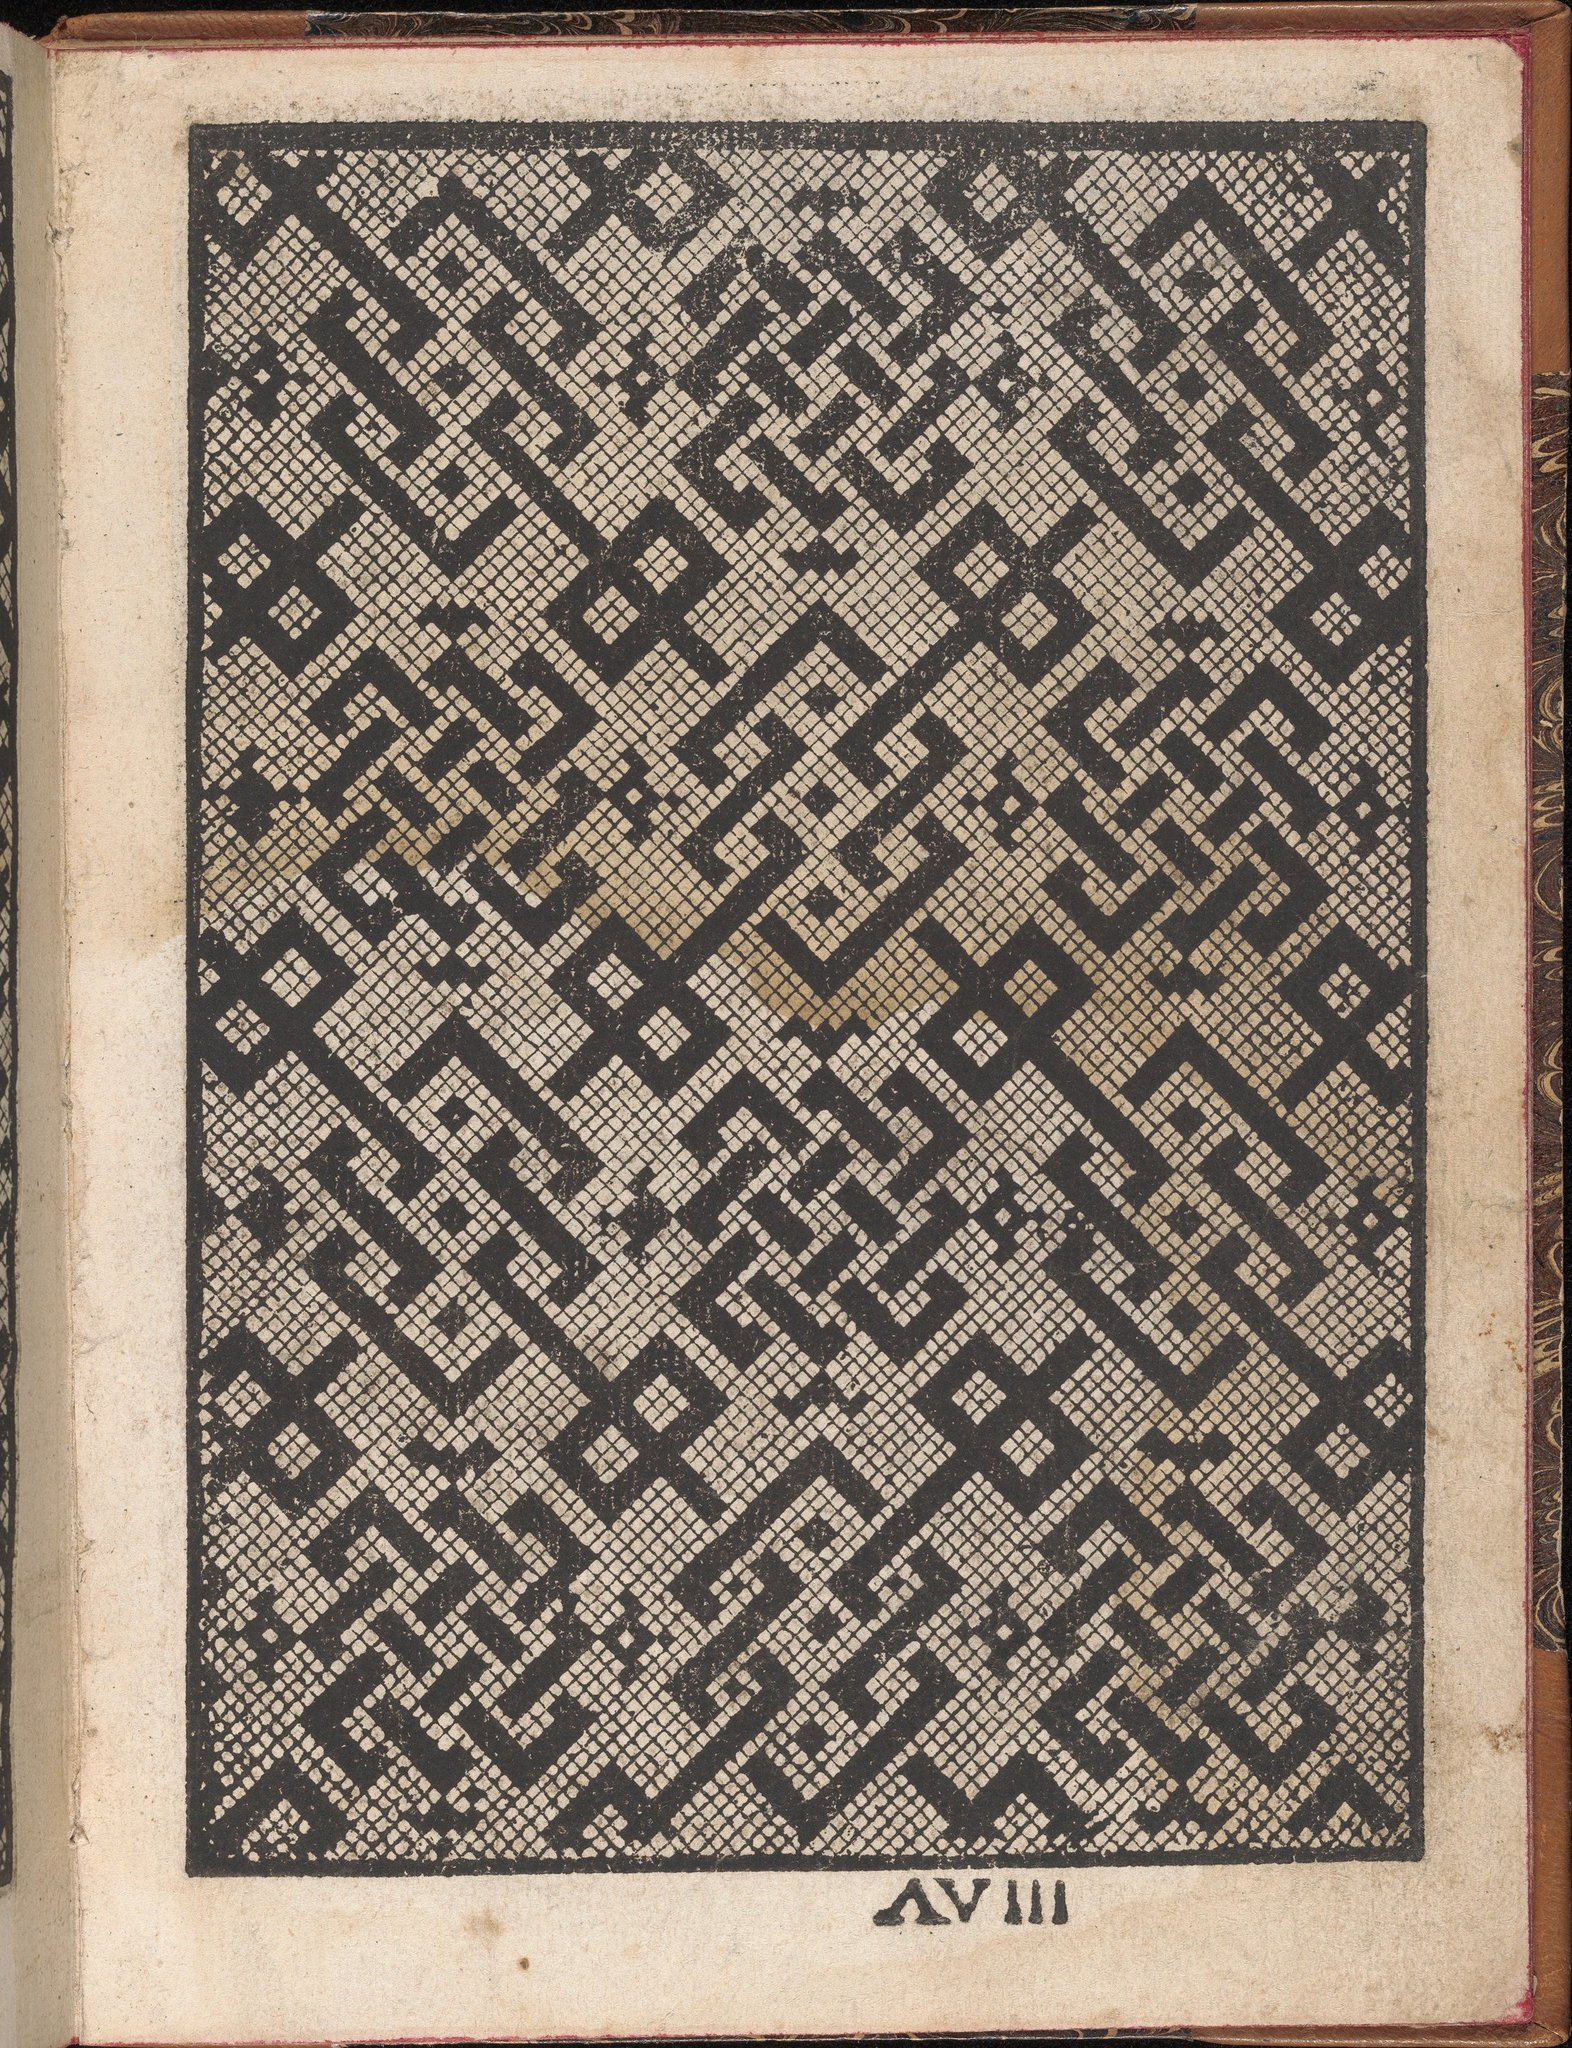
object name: book print ornament architecture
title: Spechio di pensieri delle belle et Virtudiose donne, page 7 (recto)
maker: matteo pagano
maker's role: publisher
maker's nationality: italian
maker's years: 1515-1588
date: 1546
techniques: woodcut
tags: ornament